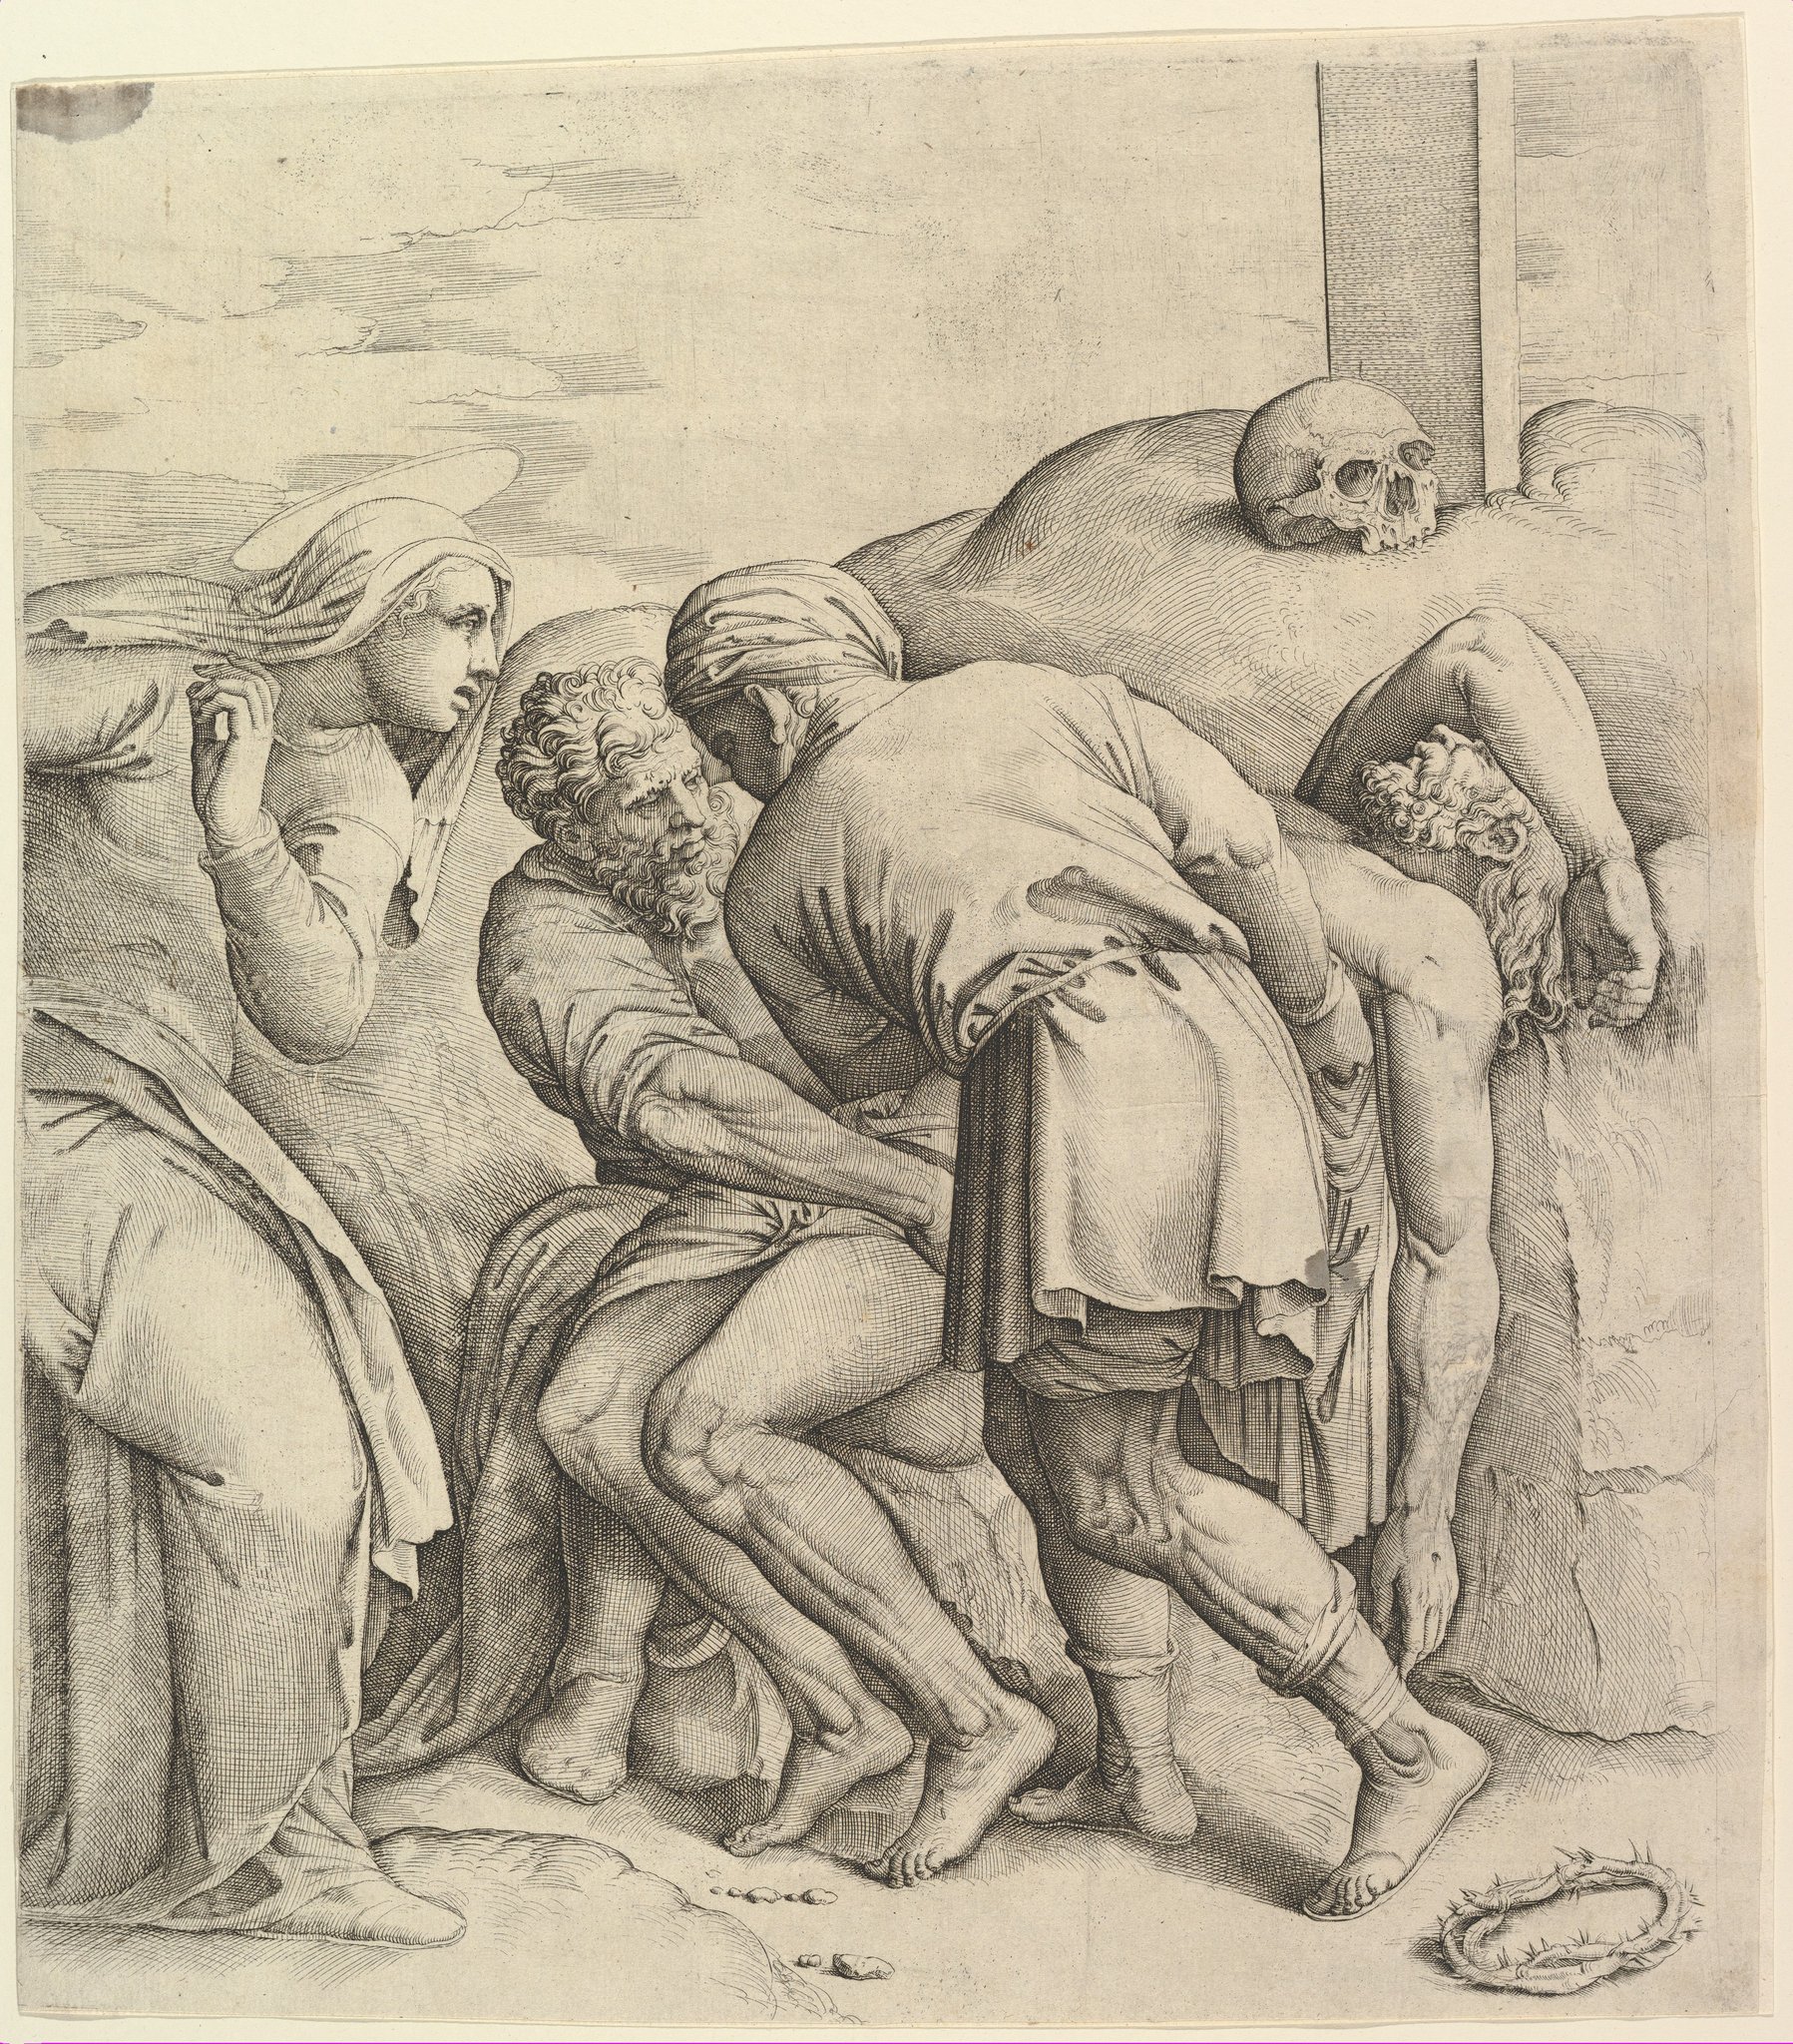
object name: print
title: The Entombment of Christ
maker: battista franco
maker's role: artist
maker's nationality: italian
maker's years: 1510-1561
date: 1530-1561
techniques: engraving, etching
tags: christ,virgin mary,entombment